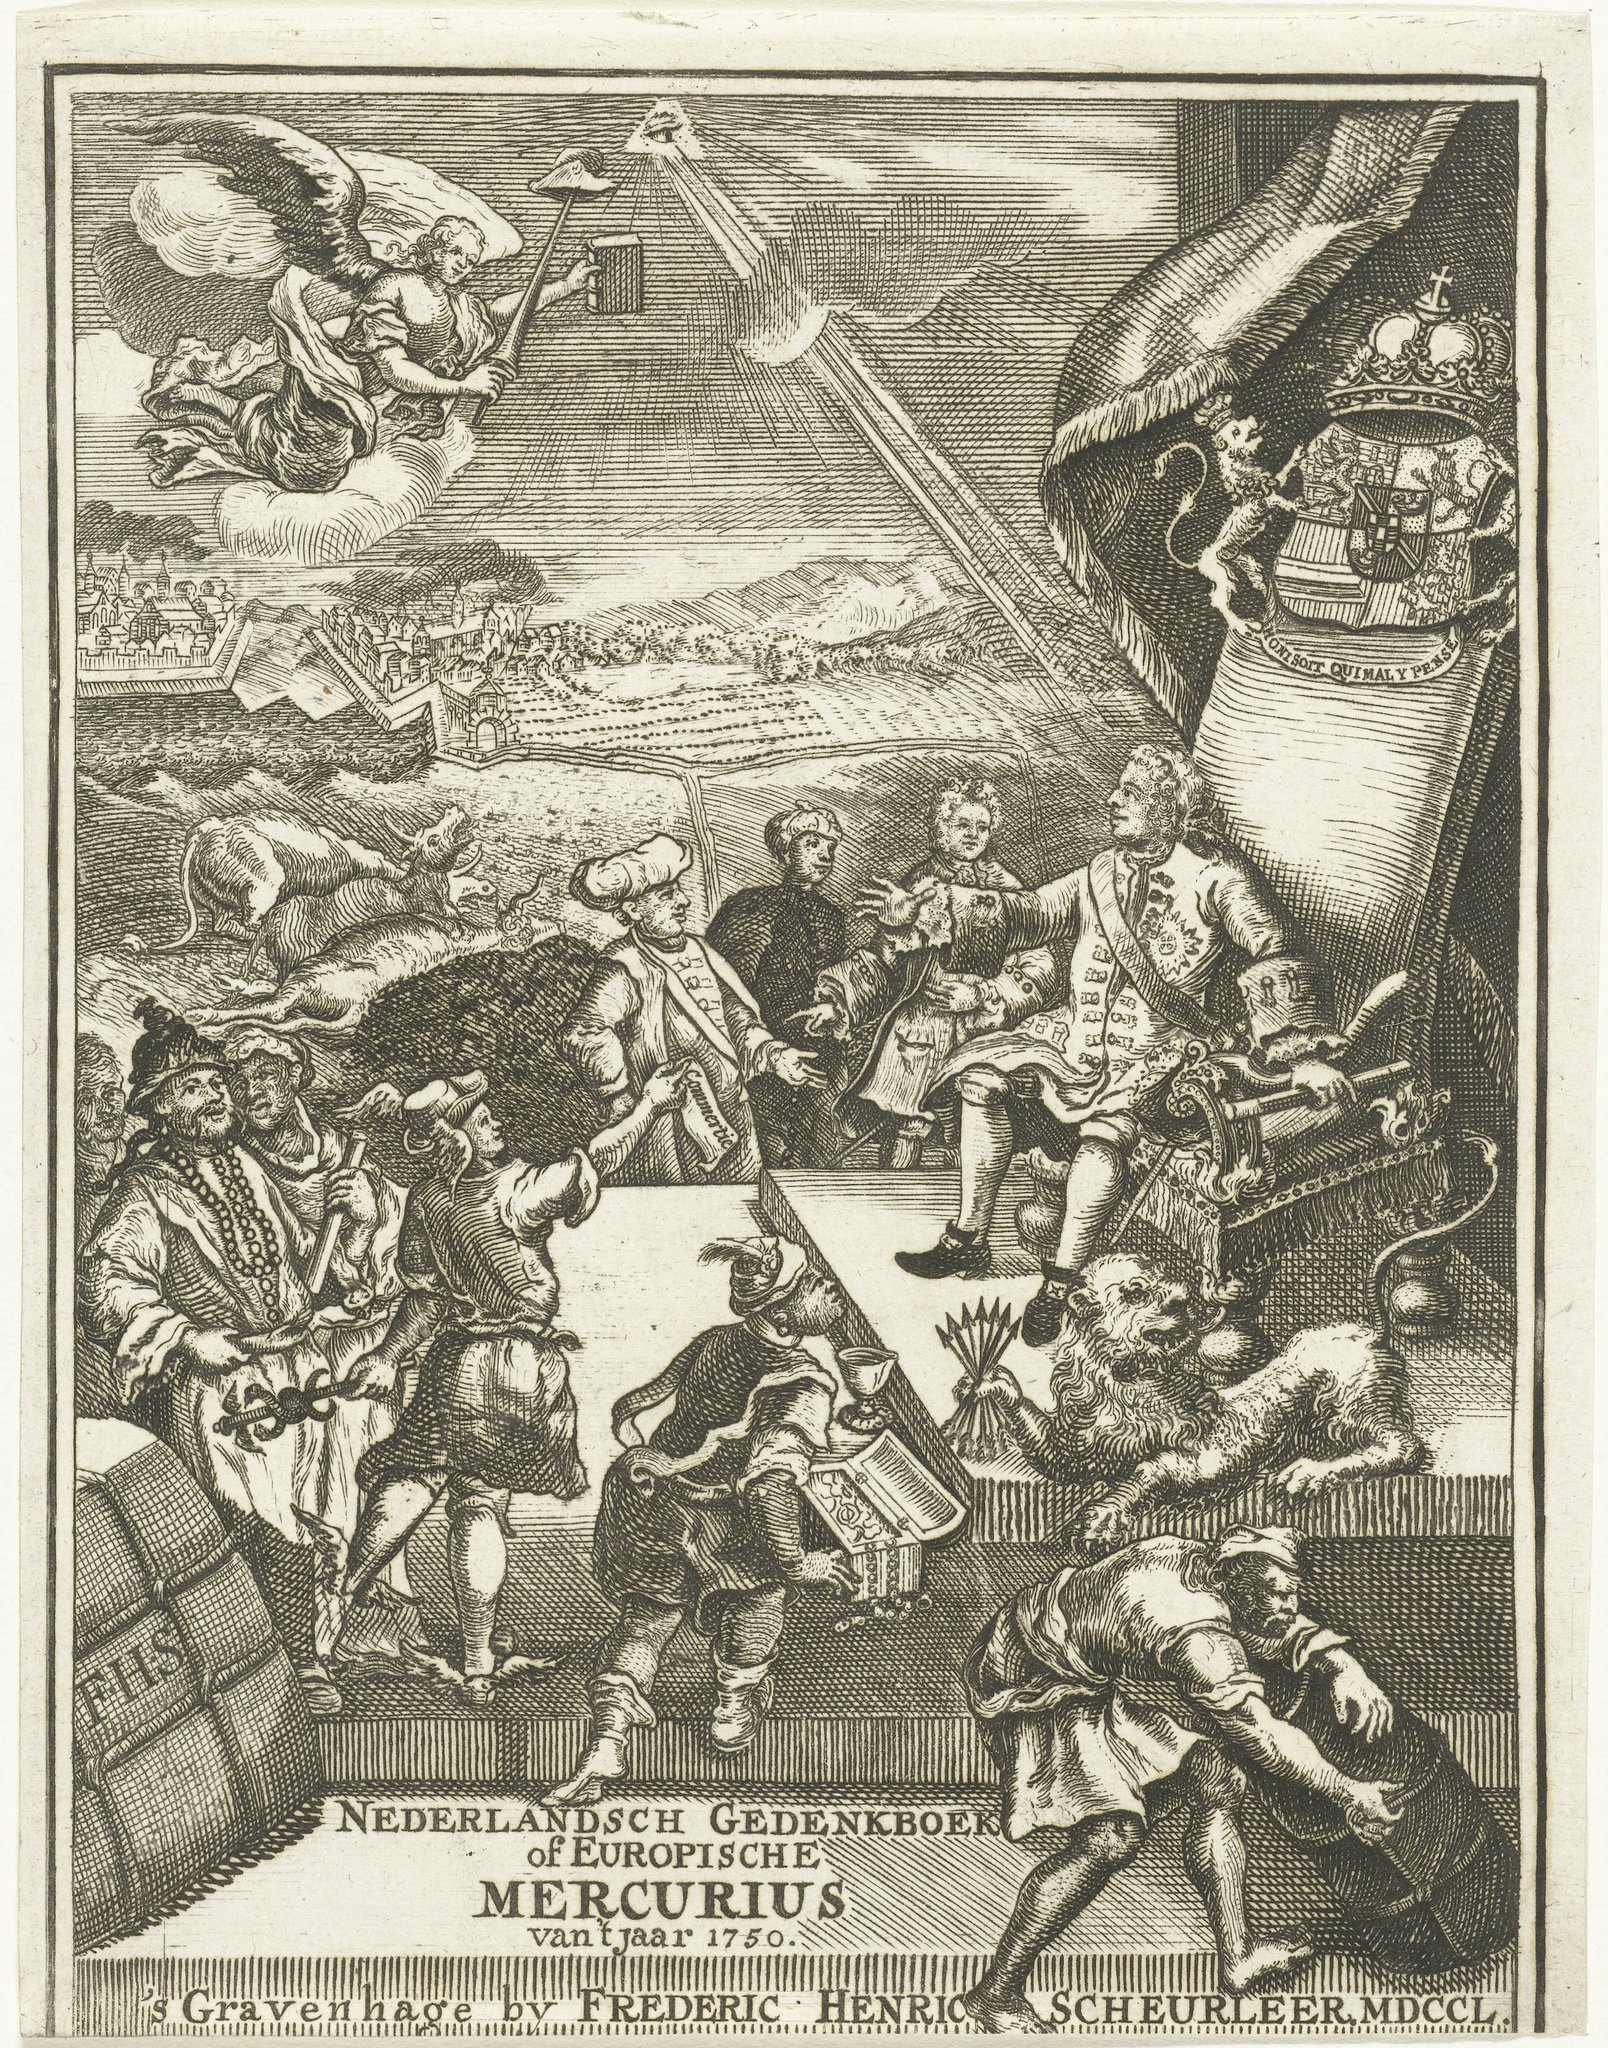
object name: titelblad, titelpagina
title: Titelpagina voor de Europische Mercurius van 1750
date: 1750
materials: paper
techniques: engraving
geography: northern netherlands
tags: the hague, willem iv (prins van oranje-nassau)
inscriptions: collector's mark: Lugt 2228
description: Titelpagina voor het Nederlandsch Gedenkboek of Europische Mercurius, over het jaar 1750. Prins Willem IV op zijn troon, aan zijn voeten Mercurius en allerlei buitenlandse kooplieden. Vanuit de hemel schijnt het alziend oog op de stadhouder.